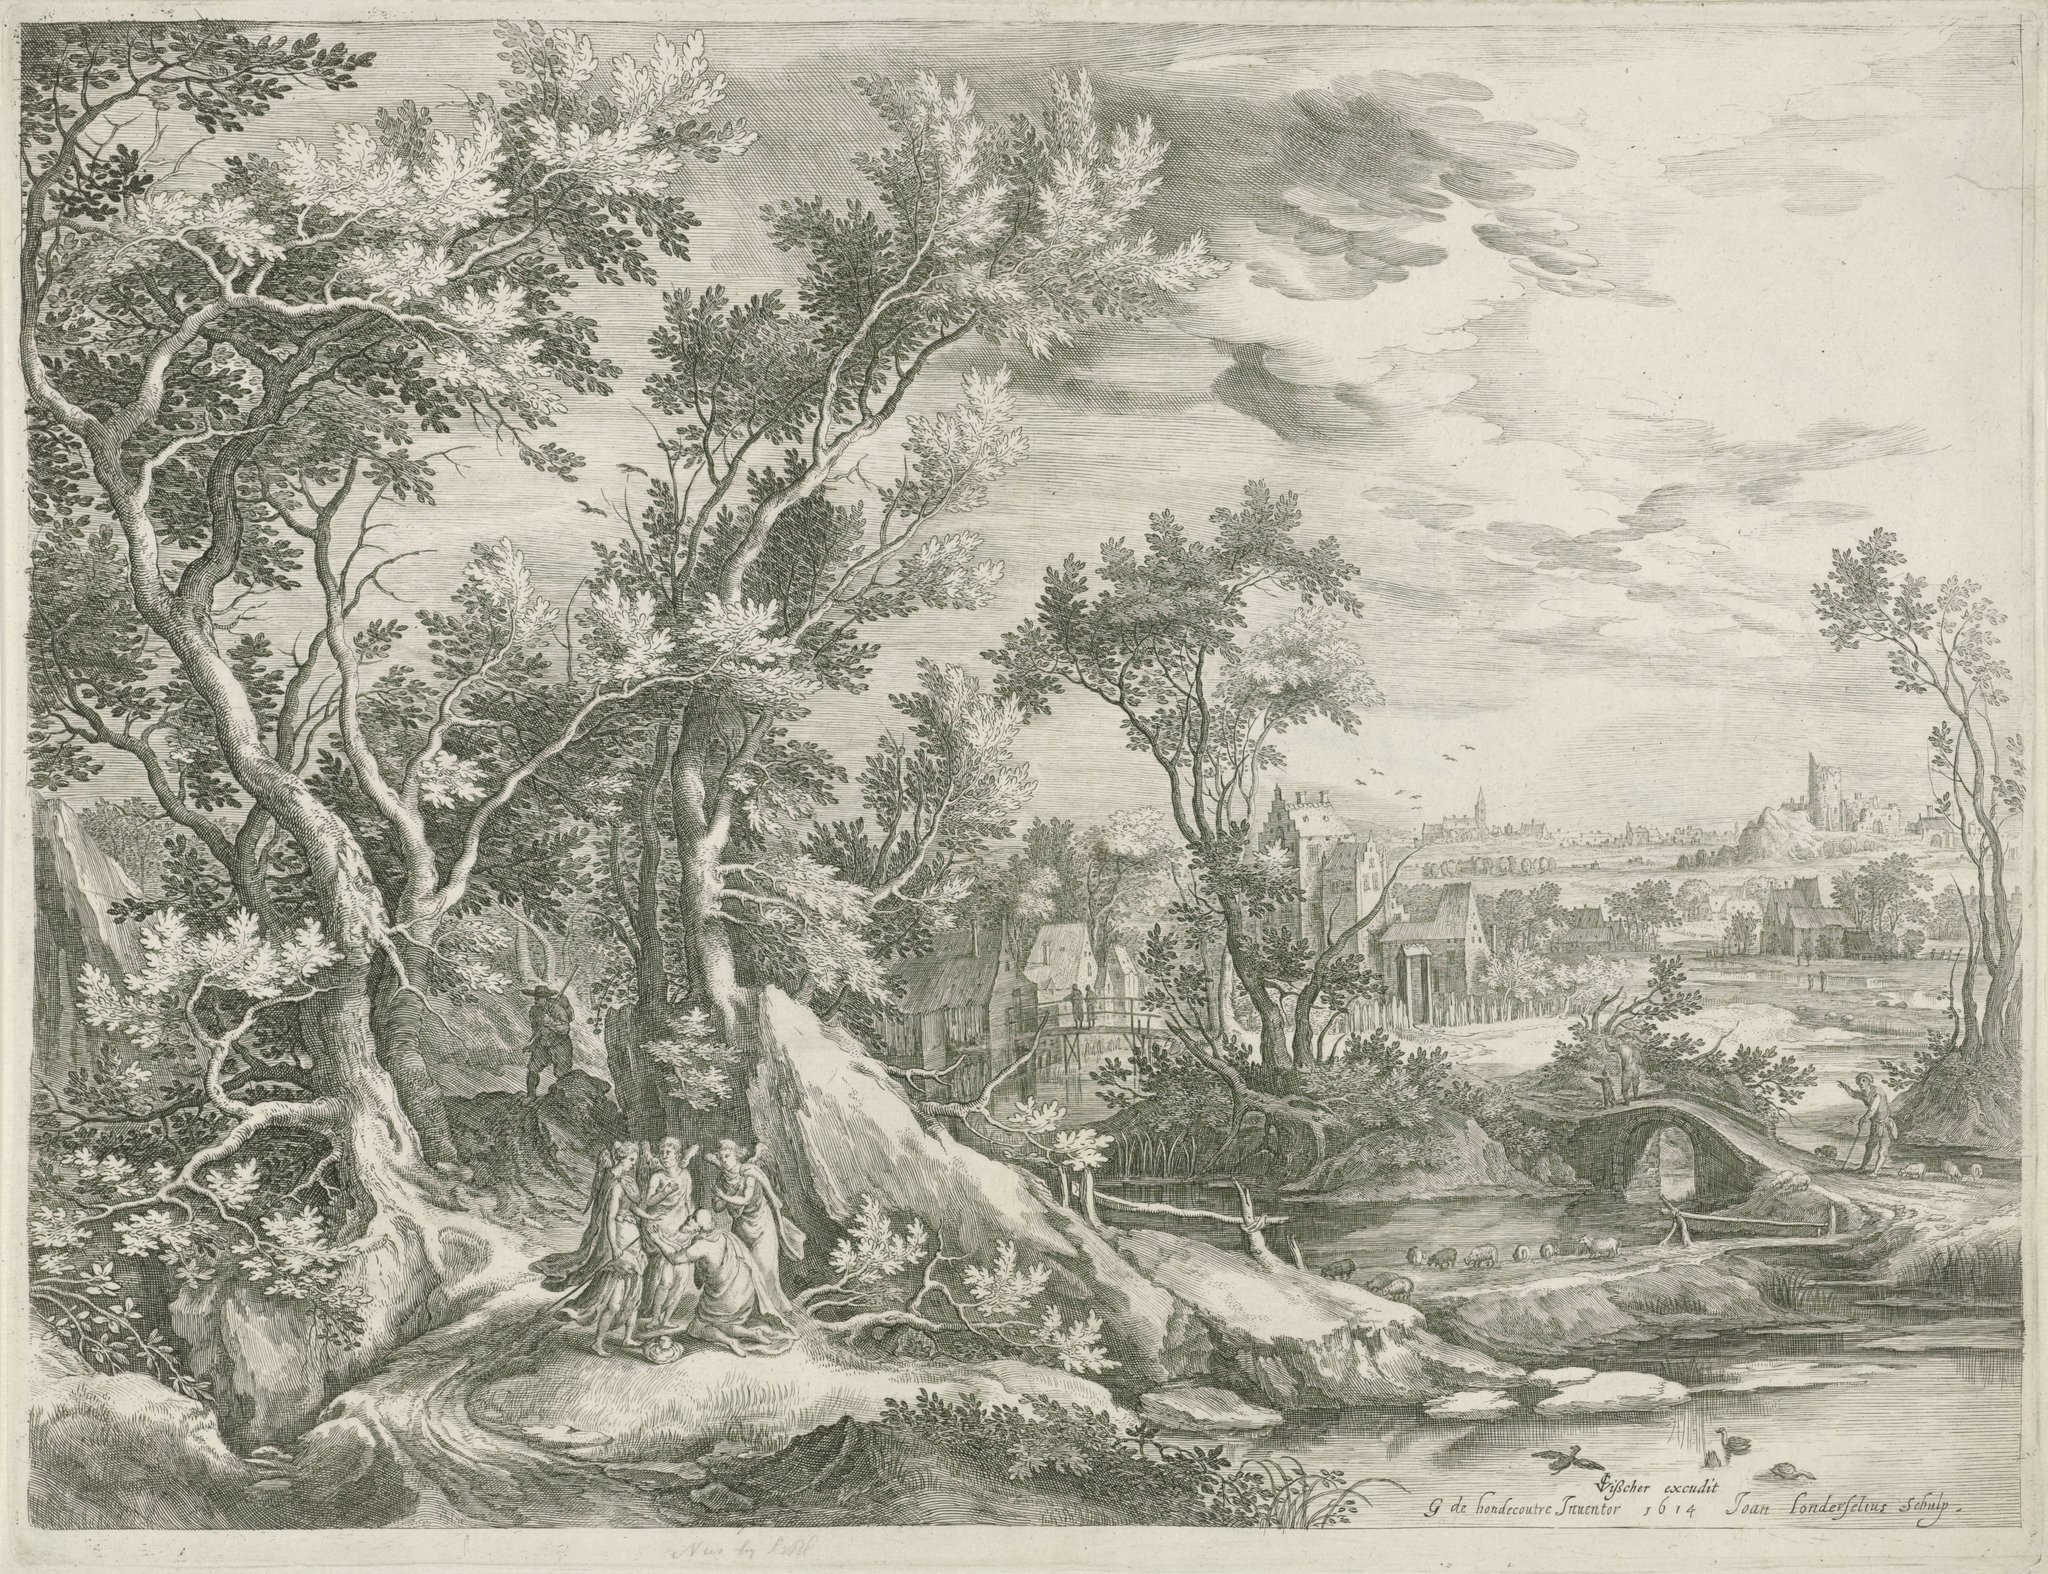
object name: print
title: Landschap met Abraham die de drie engelen smeekt Sodom te sparen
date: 1614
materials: paper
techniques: engraving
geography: amsterdam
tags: landscapes with waters, waterscapes, seascapes (in the temperate zone), abraham kneels before the angels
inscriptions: collector's mark: Lugt 2228, inscription: ‘Dubbel. Dezelfde prent als A 18306.’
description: Prent gebruikt in: Historiae Sacrae Veteris et Novi Testamenti (Royaalbijbel). Amsterdam: Nicolaes Visscher (I), [1652-1702]. In de fondslijst van Nicolaes Visscher II (ca. 1680) is het onderwerp van deze prent onder de titel 'Bybelsche Figuren, op Royaal-bladen. bestaande uyt de volgende historien.' als volgt genummerd: 8.